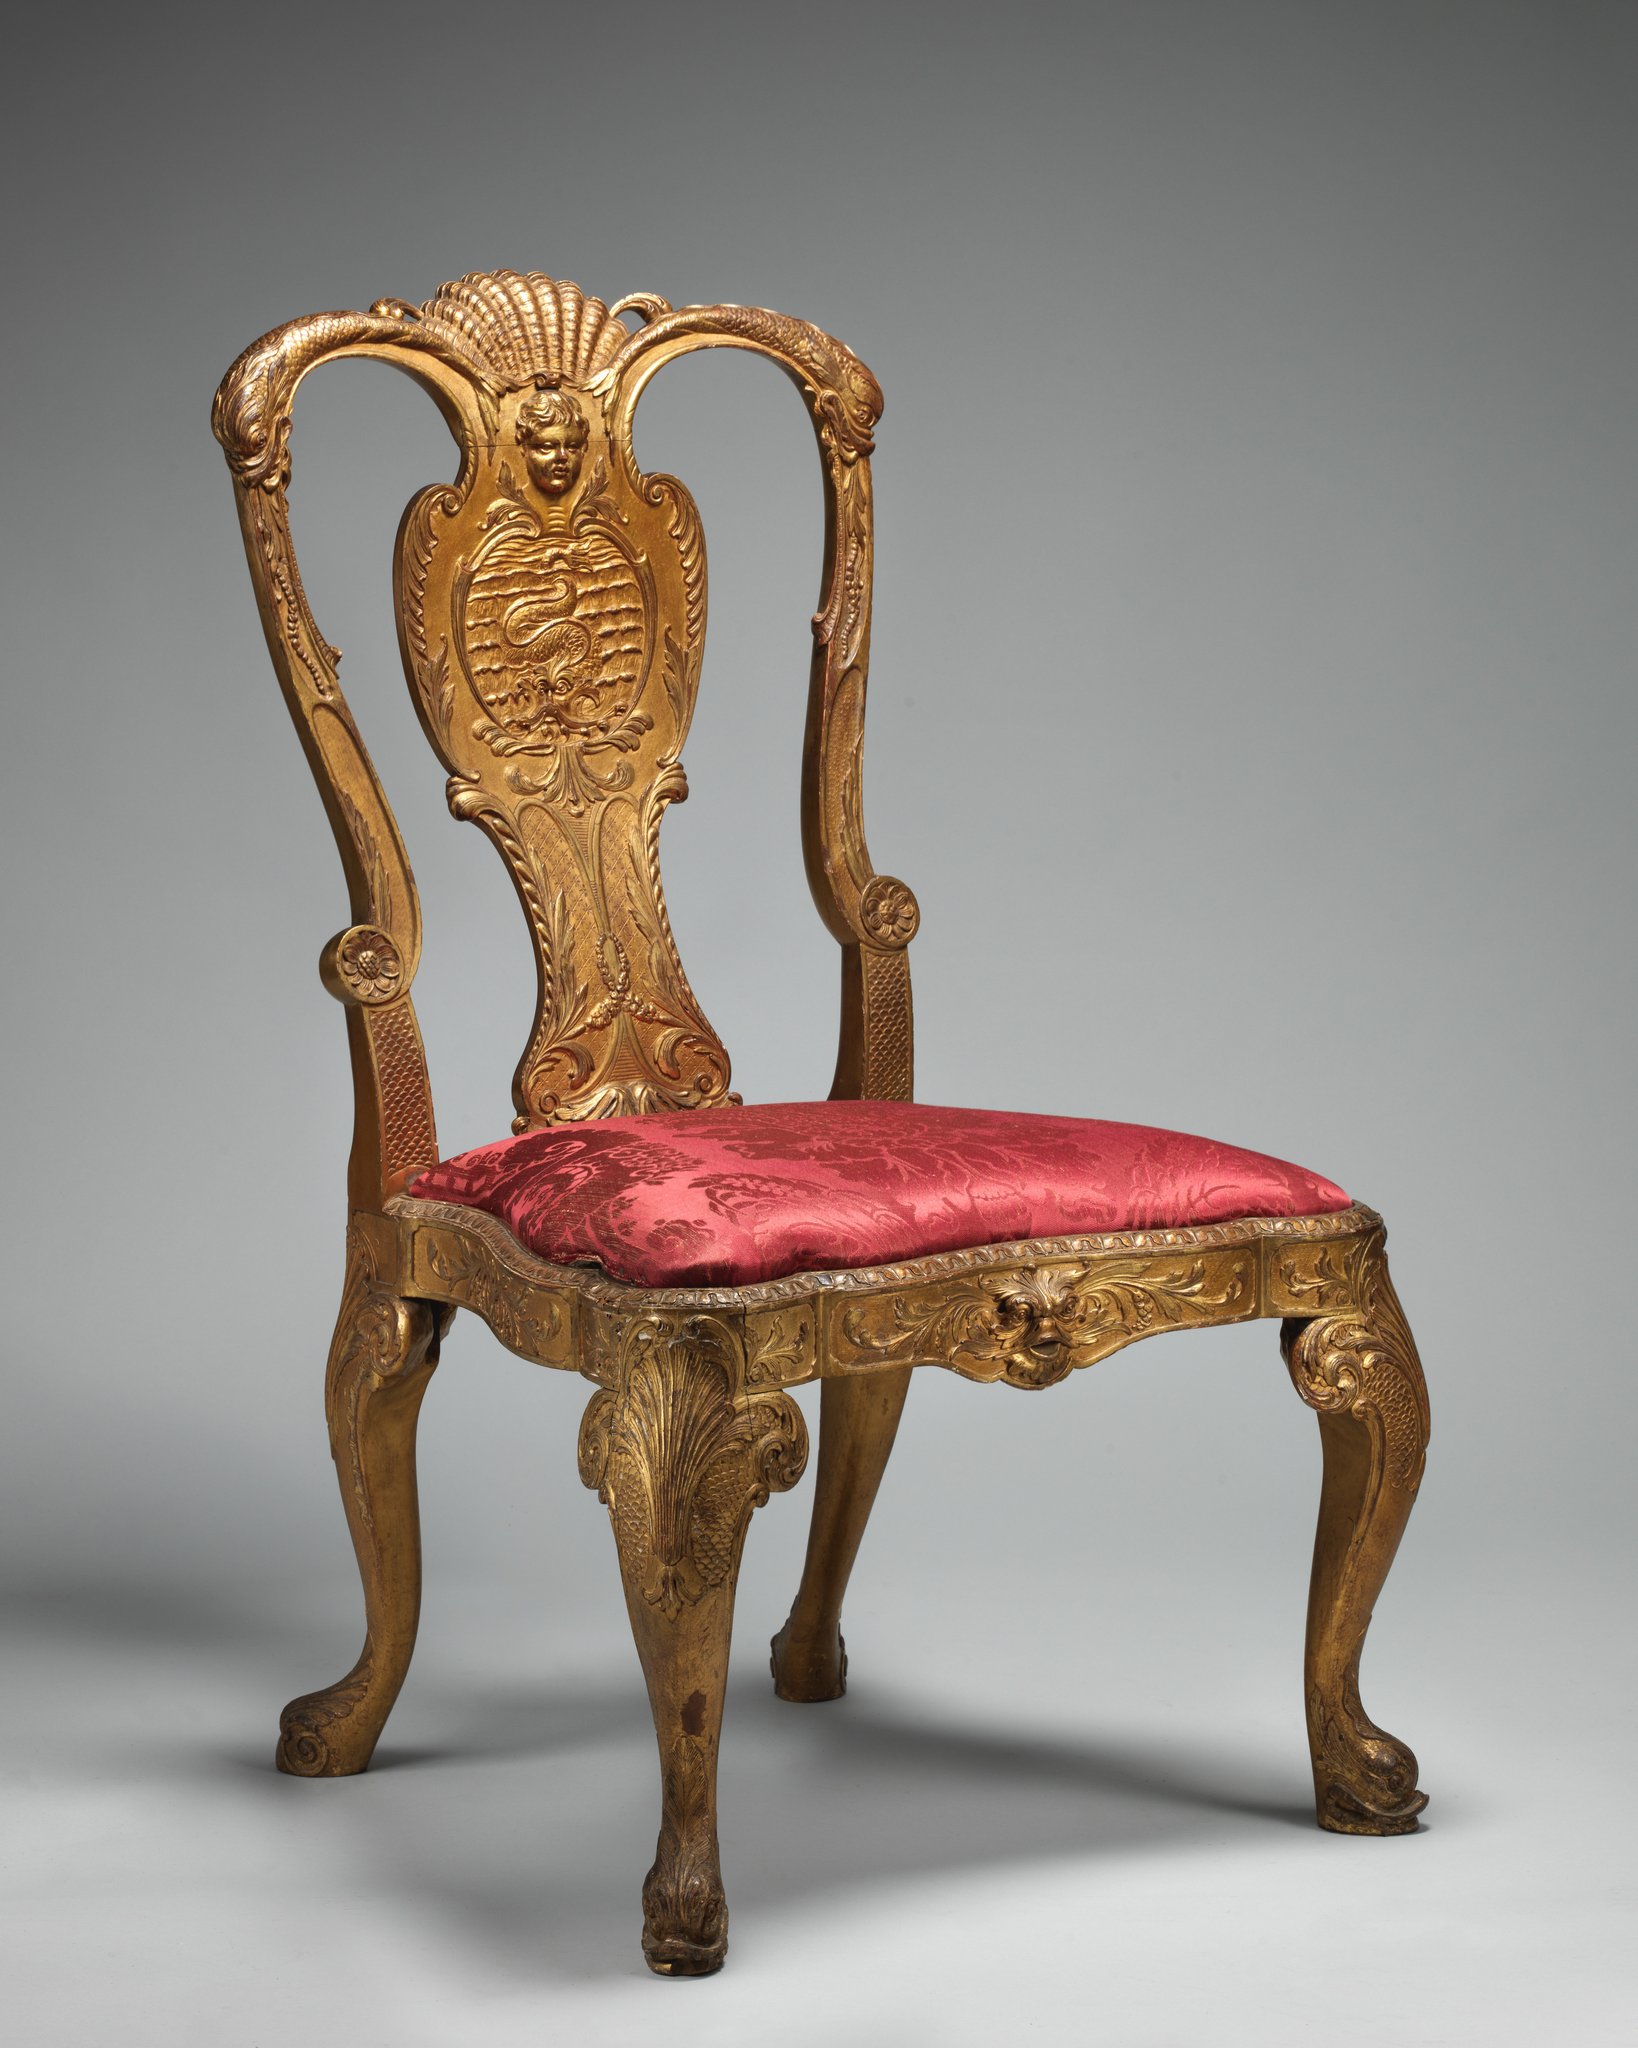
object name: side chair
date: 1725-1735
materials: gesso, wood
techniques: gilding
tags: faces